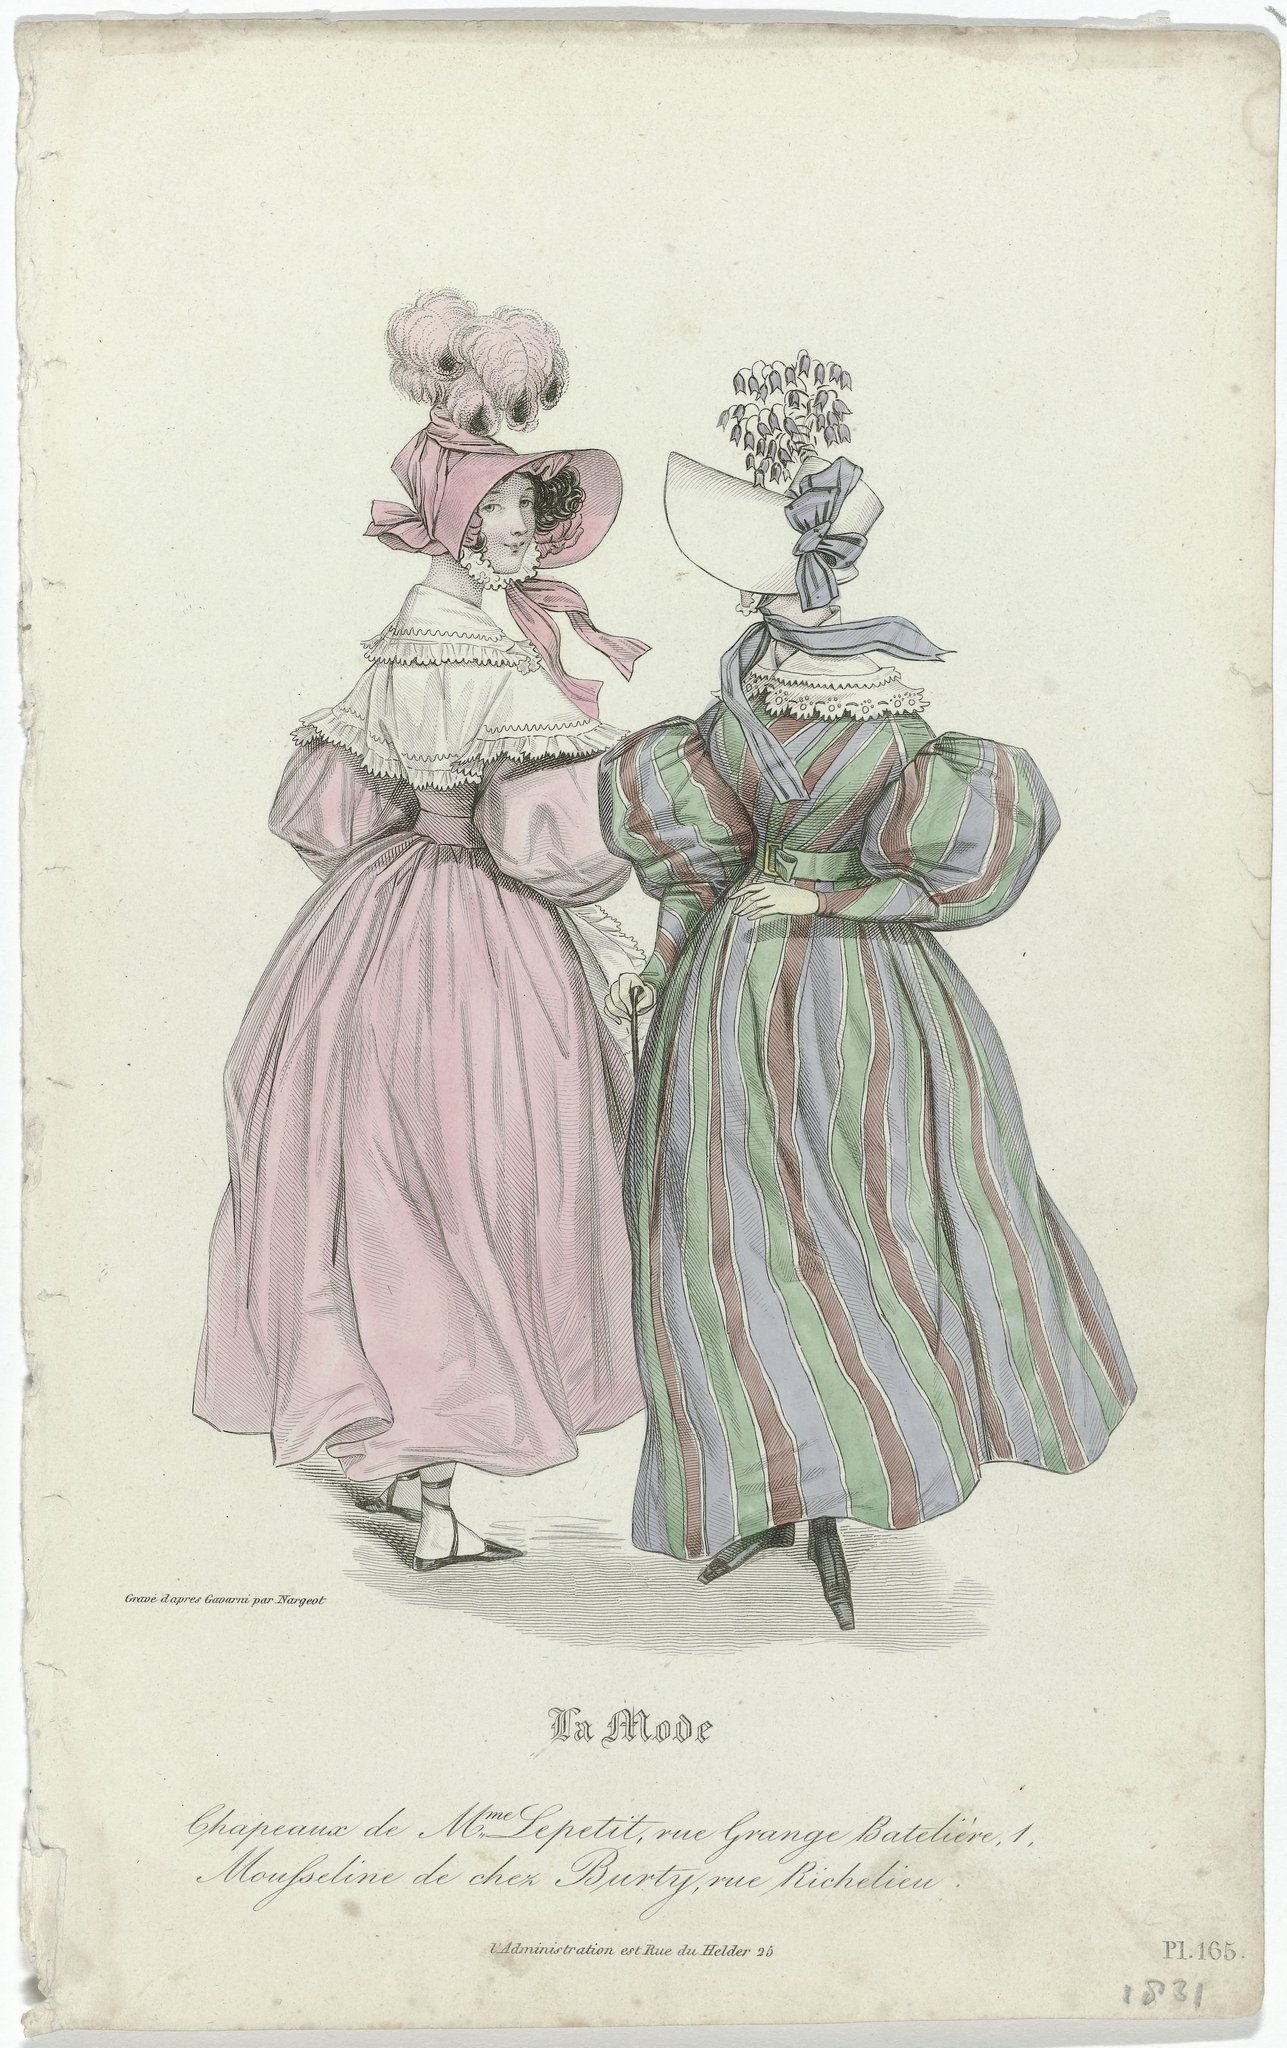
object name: fashion print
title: La Mode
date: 1831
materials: paper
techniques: hand coloring, engraving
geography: paris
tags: clothing for the upper part of the body (+ women's clothes), boots (+ women's clothes), fashion plates, head-gear: hat (+ women's clothes), shoes, sandals (+ women's clothes), gloves, mittens, etc. (+ women's clothes), dress, gown (+ women's clothes), neck-gear ~ clothing (+ women's clothes), belt, girdle, waistband (+ women's clothes)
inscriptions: caption: ‘Chapeaux de M"me Lepetit, rue Grange Batelière, 1, Mousseline de chez Burty, rue Richelieu.’, address: ‘L'Administration est Rue du Helder 25.’, title: ‘La Mode.’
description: On launching his society magazine La Mode (1829- 1955), the publisher Girardin criticized other fashion magazines for their ‘stiff, mechanical mannequins’. He wanted pictures that were more modern and animated. In illustrator Paul Gavarni, who had a reputation as the best-dressed man in Paris, he found just the right man to put a fresh spin on the fashion plate and to make the stiff ‘mannequins’ come to life.